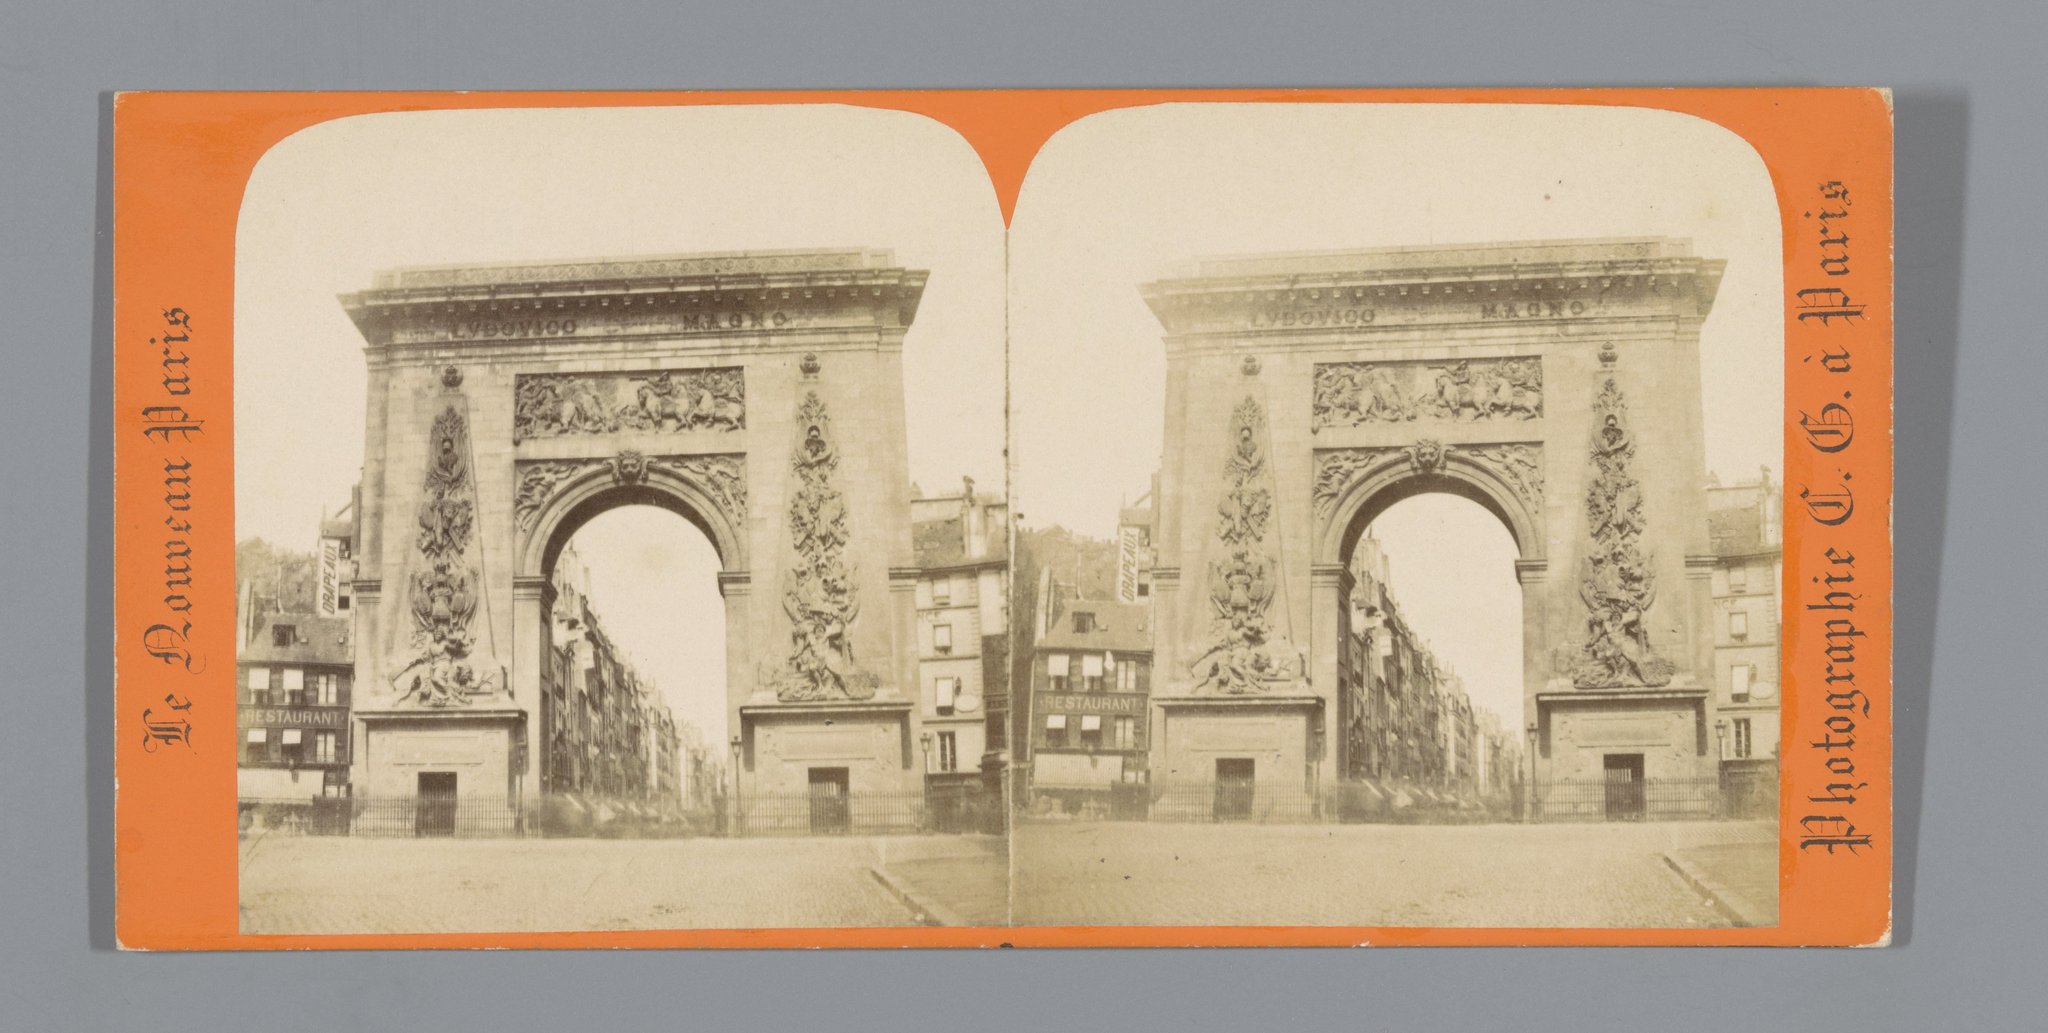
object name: stereograph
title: Gezicht op de Porte Saint-Denis te Parijs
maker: charles gérard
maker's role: fotograaf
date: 1860-1870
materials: cardboard, photographic support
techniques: albumen print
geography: paris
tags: triumphal arch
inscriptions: inscription: ‘Porte St Denis’, inscription: ‘Photographie C. G. à Paris.’